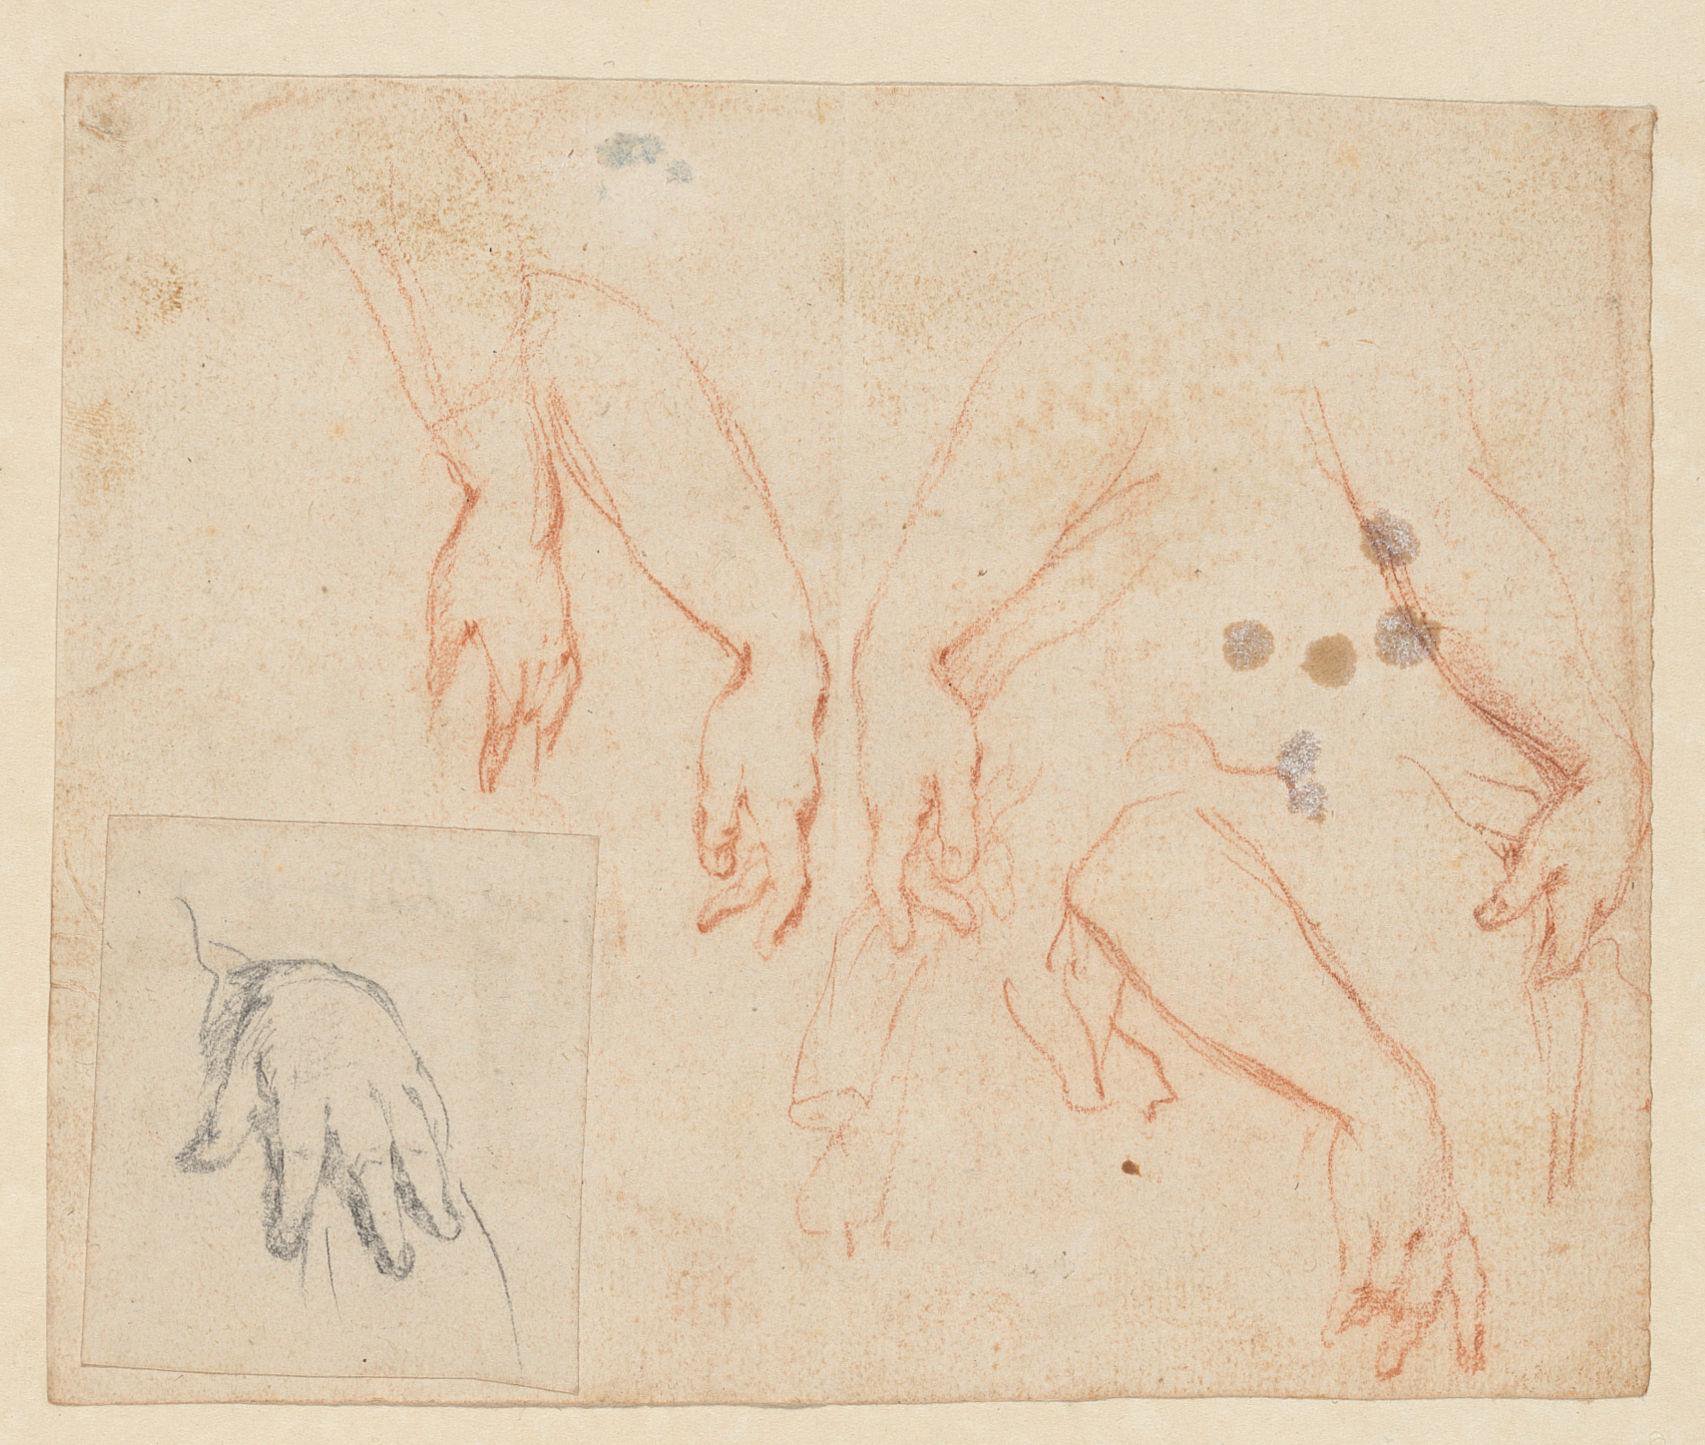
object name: album leaf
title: Studie van armen en handen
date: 1649-1723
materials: chalk, paper, pencil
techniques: pasting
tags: postures and gestures of hand and fingers, lower arm